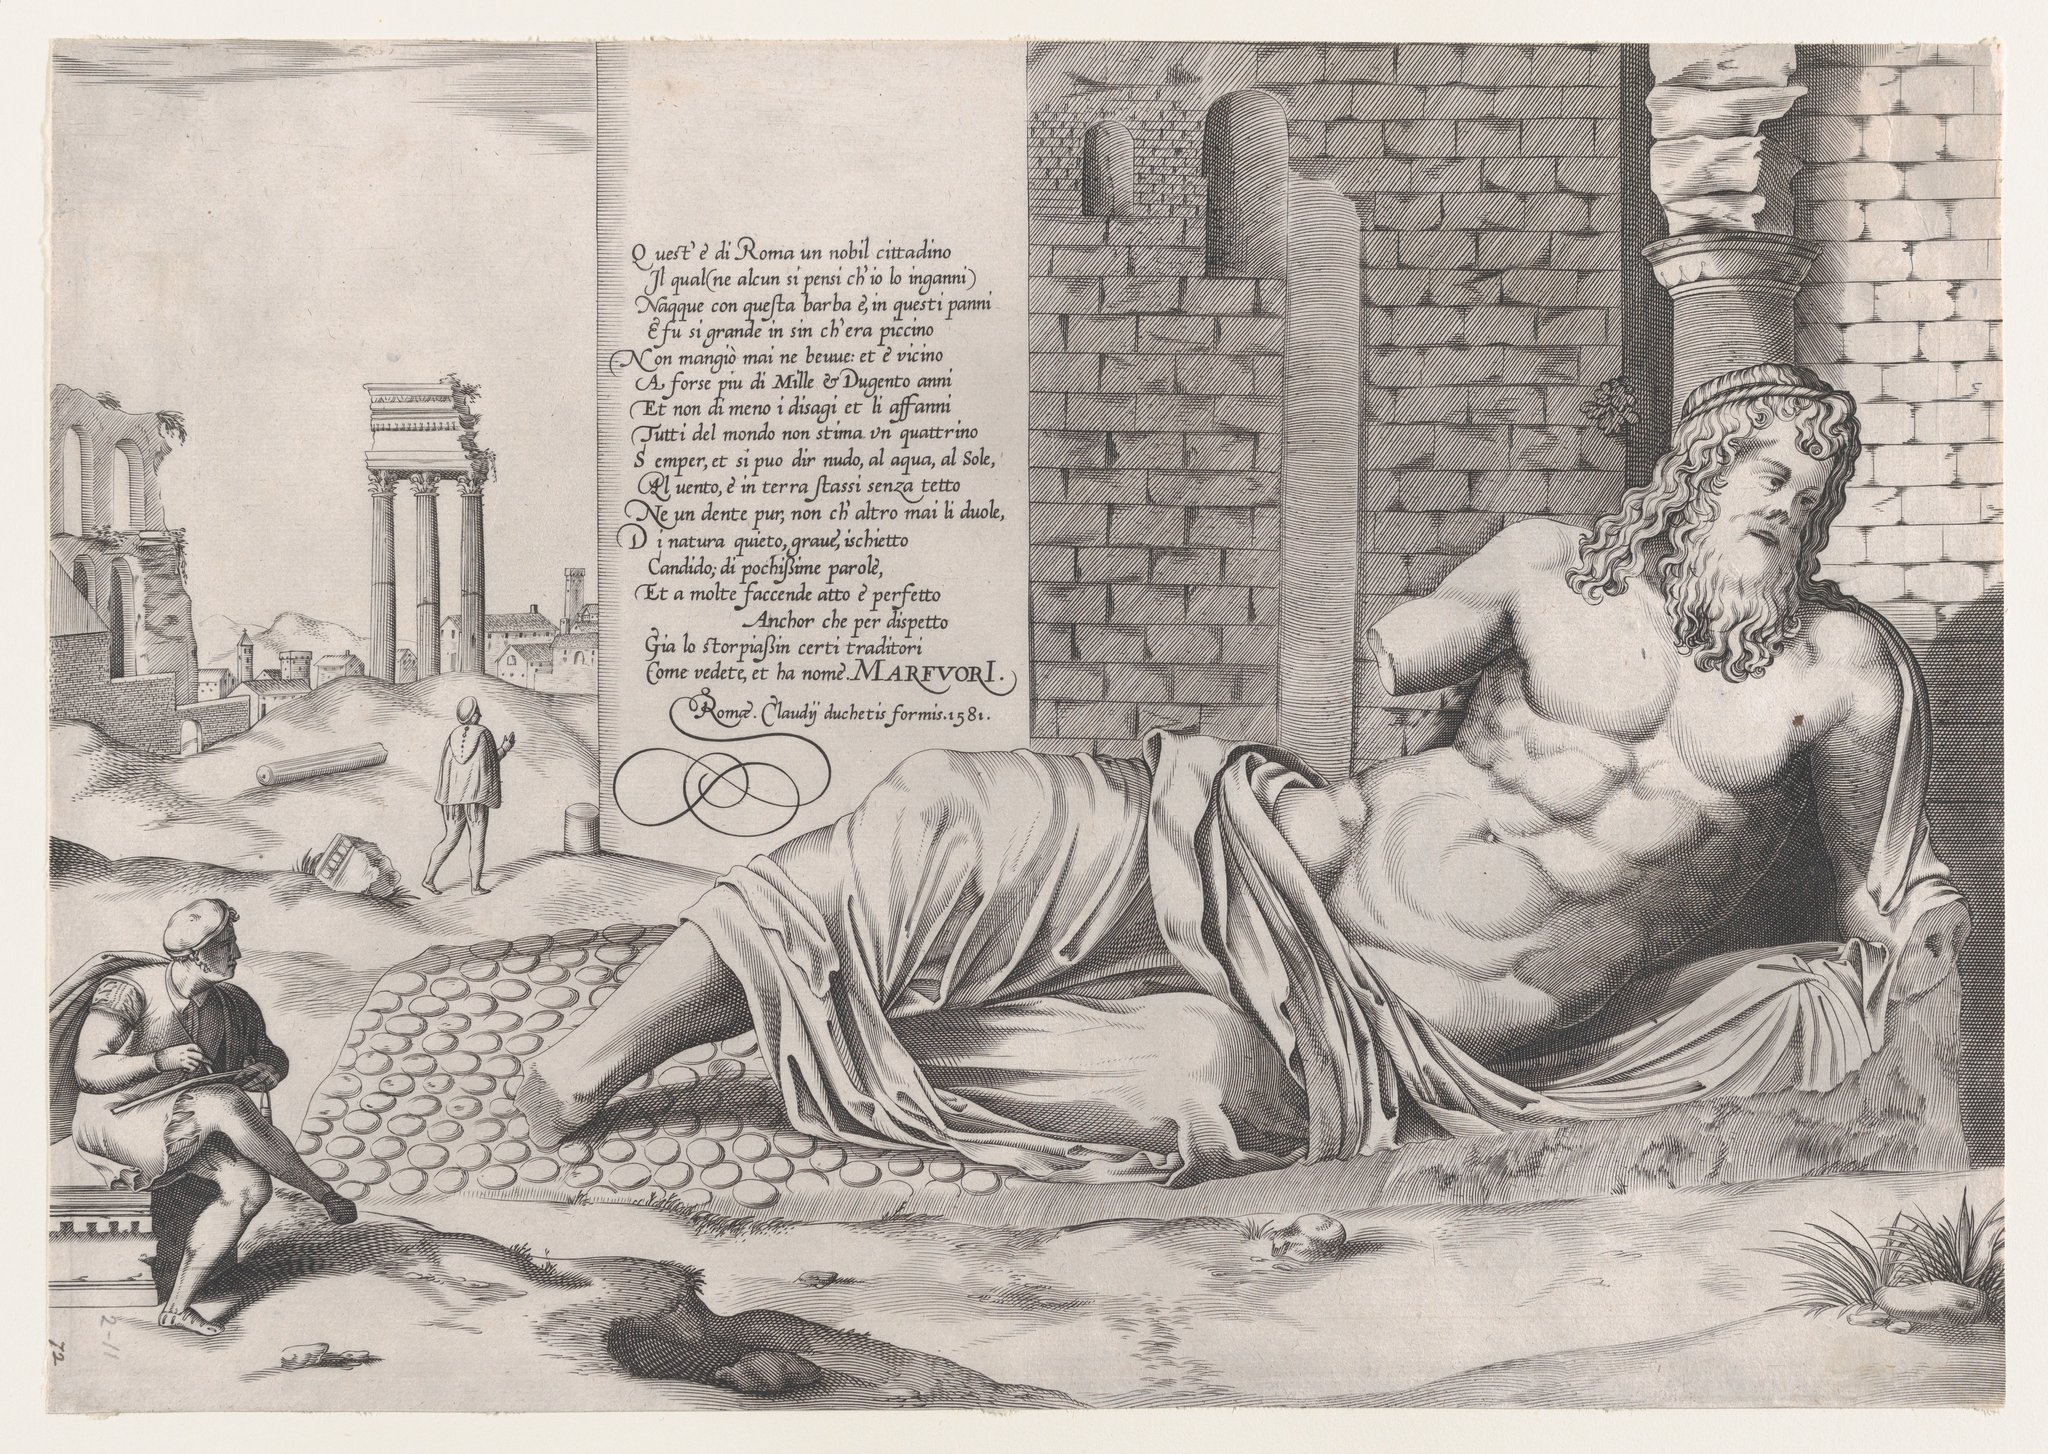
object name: print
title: Marforius, from "Speculum Romanae Magnificentiae"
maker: Anonymous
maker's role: artist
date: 1581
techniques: etching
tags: sculpture,ruins,men